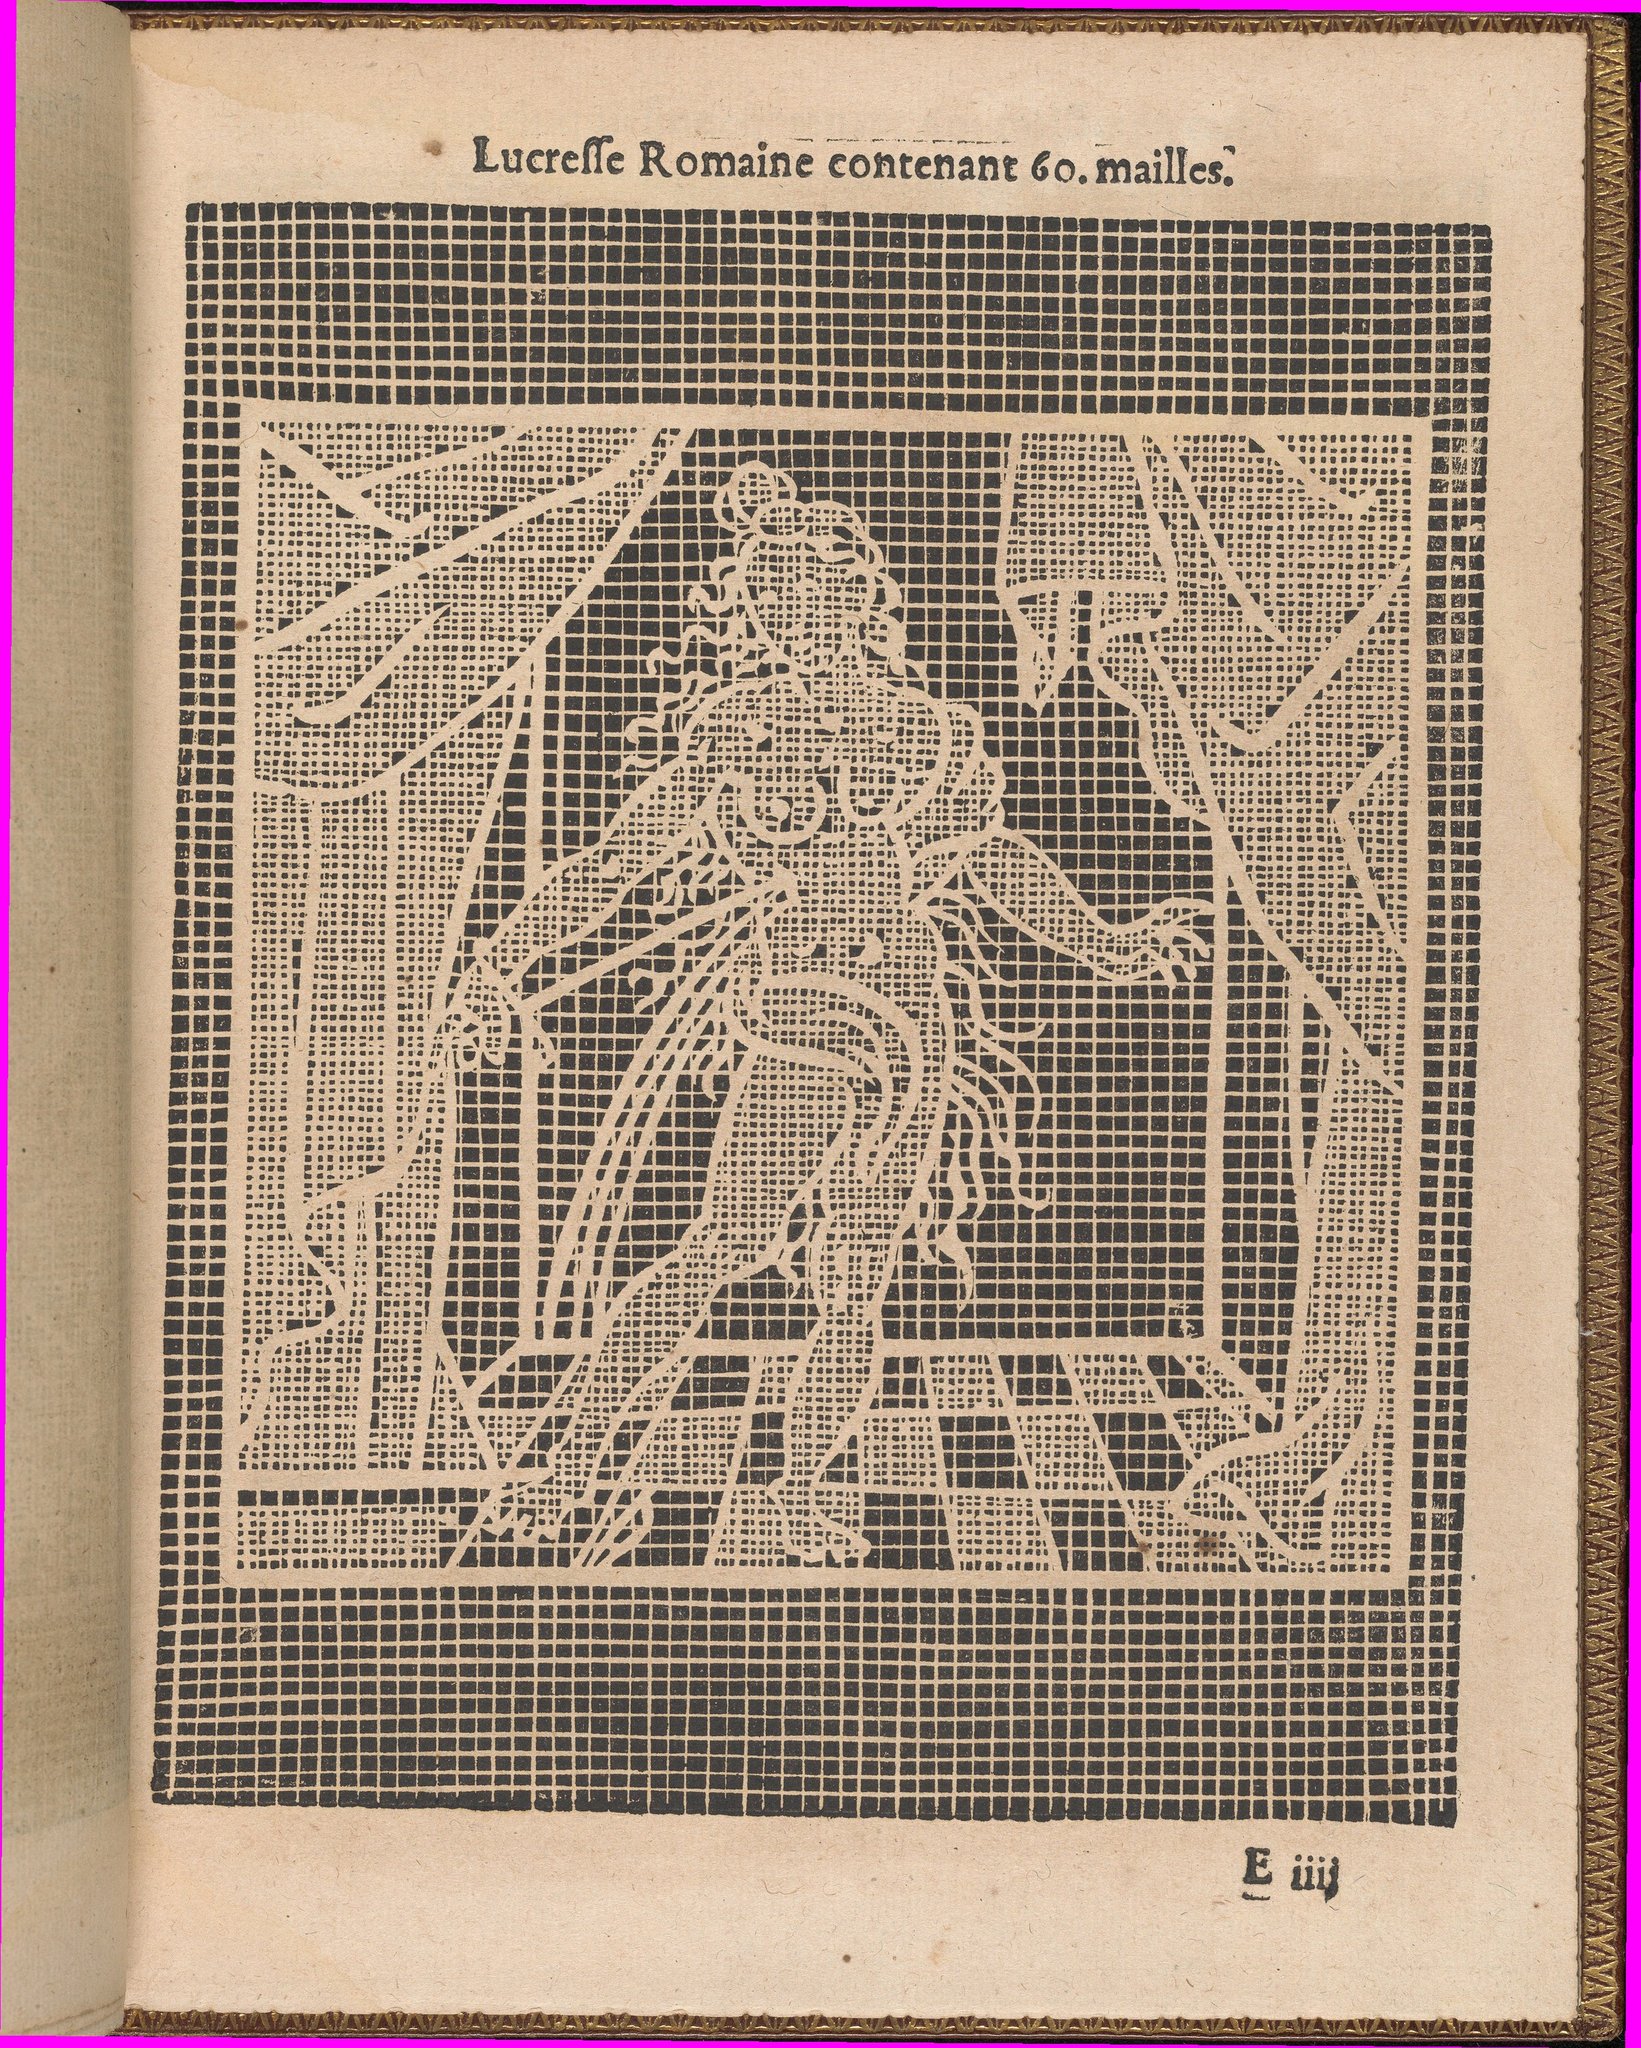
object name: book print ornament architecture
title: La Pratique de l'Aiguille, page 19 (recto)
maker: matthias mignerak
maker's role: author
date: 1605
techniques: woodcut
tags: ornament,women